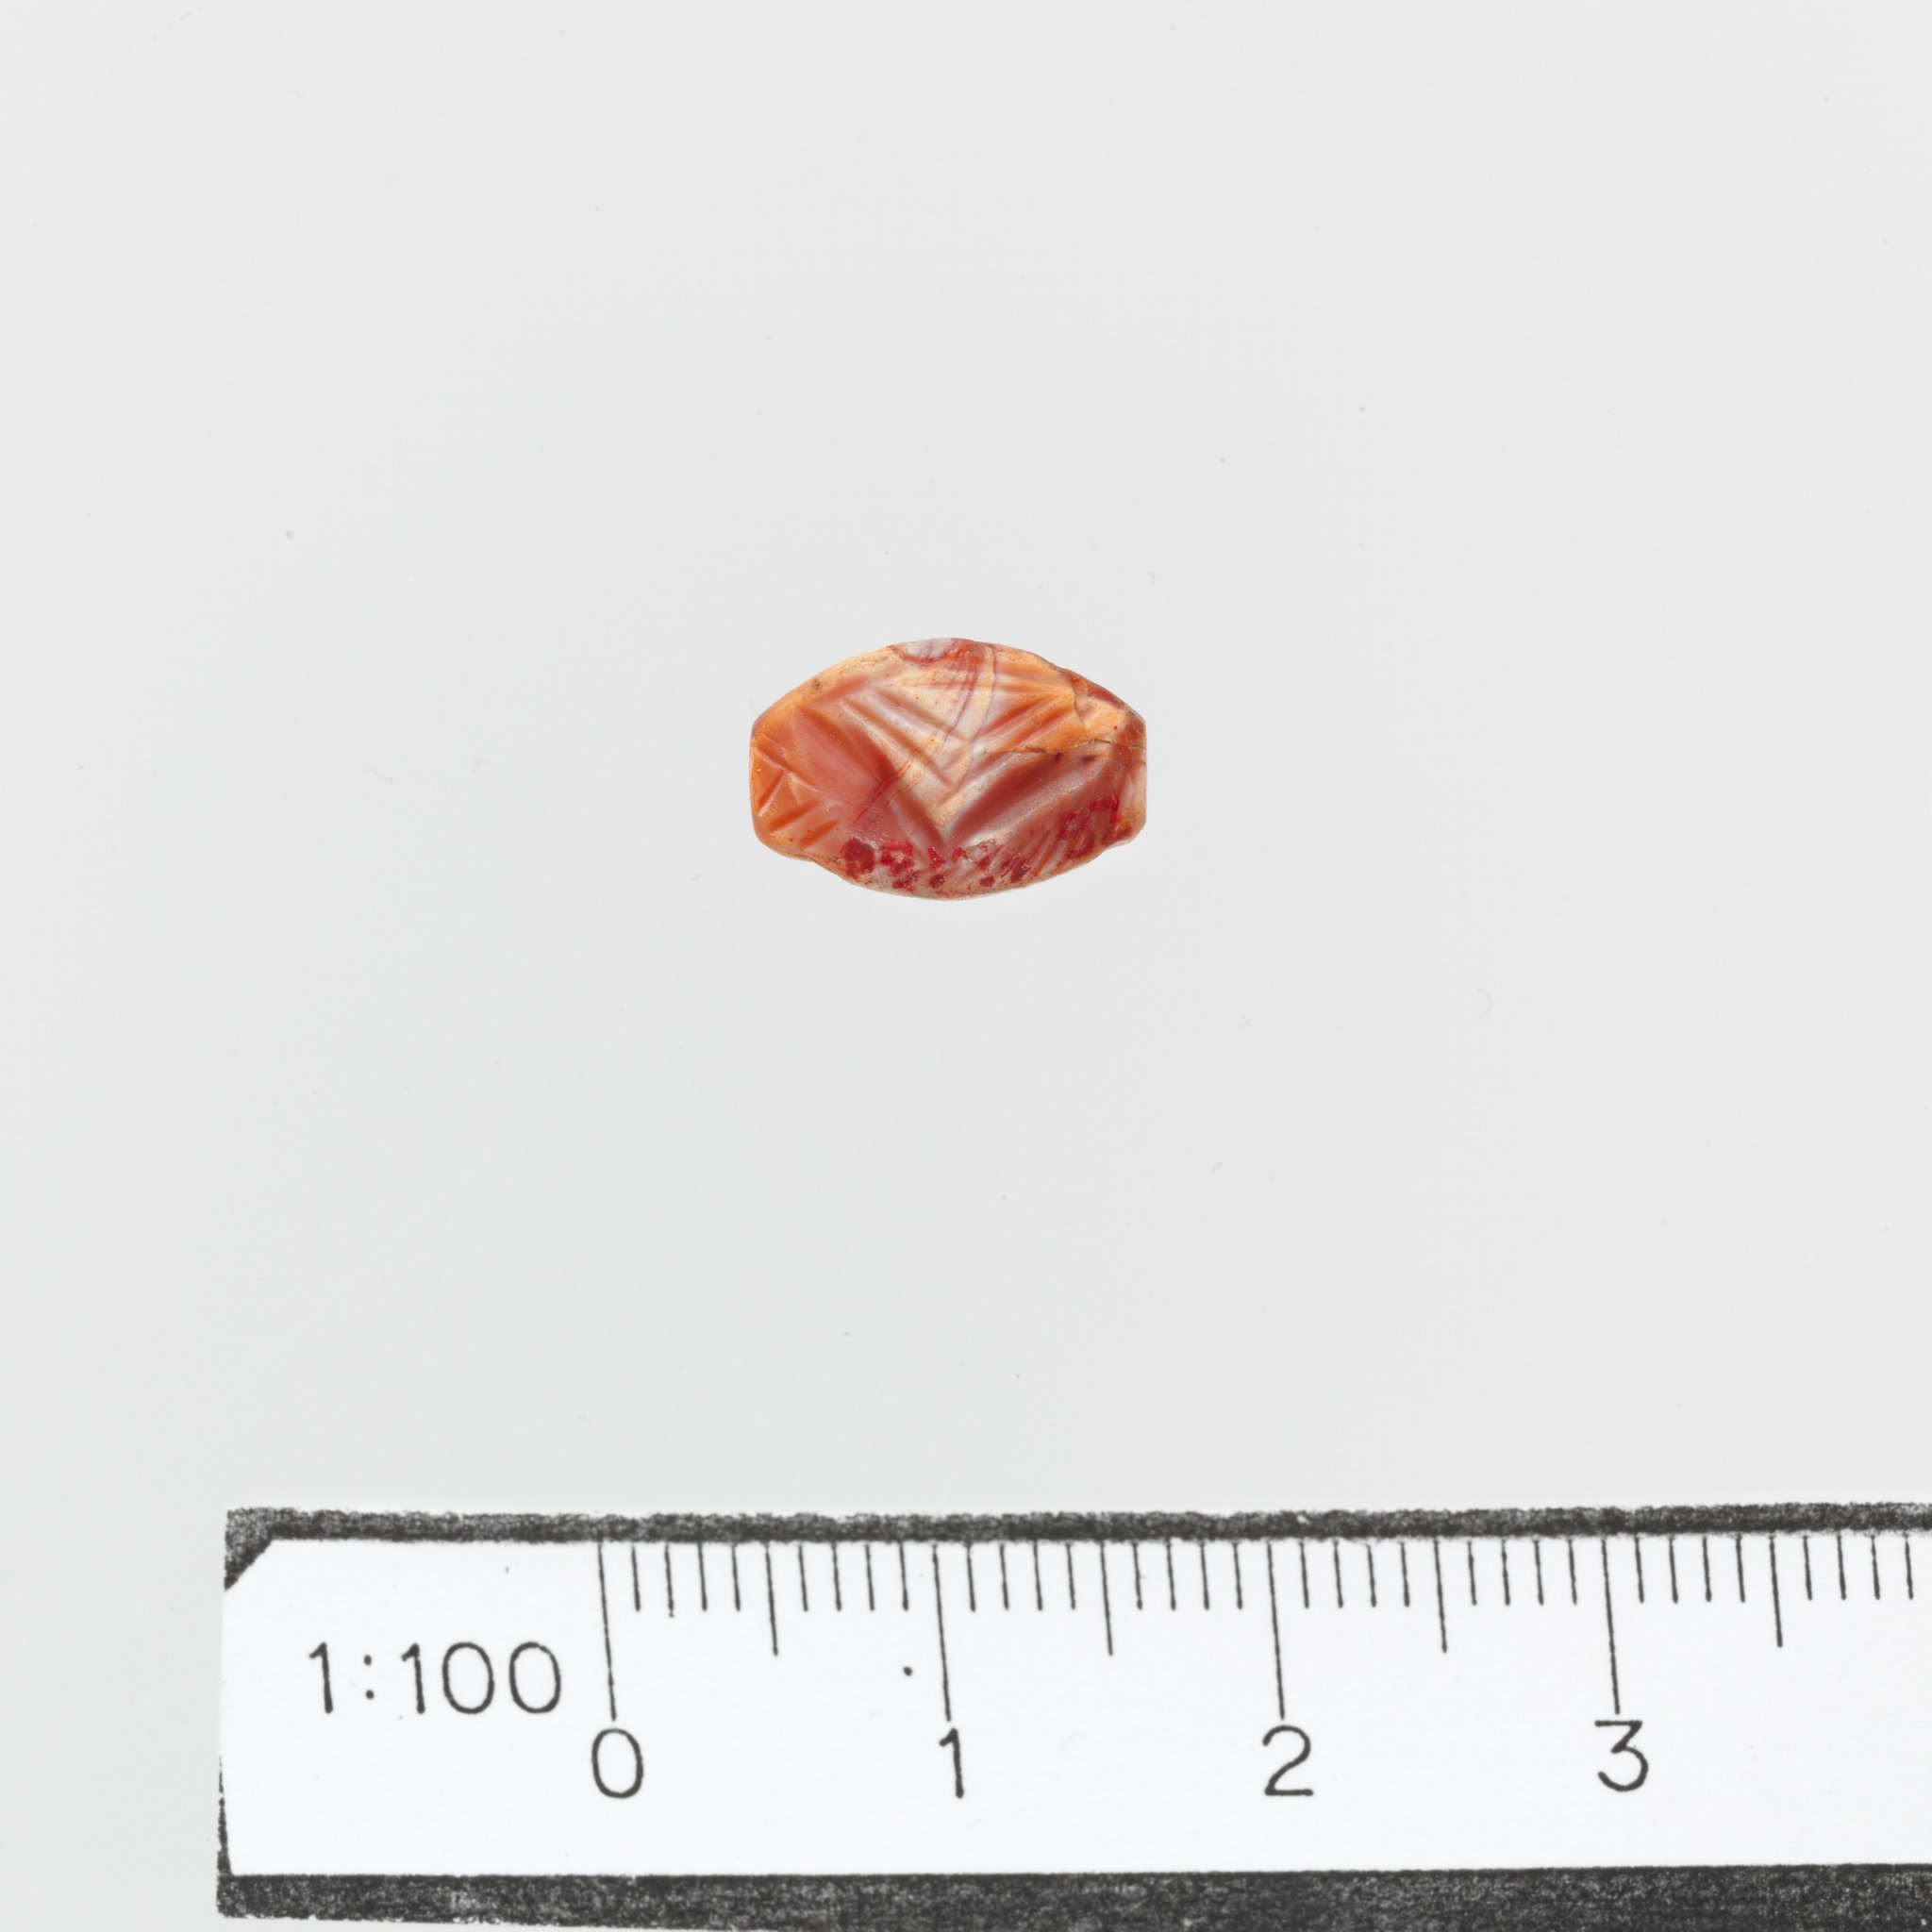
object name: seal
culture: minoan, crete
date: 2000-1450 BCE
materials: stone